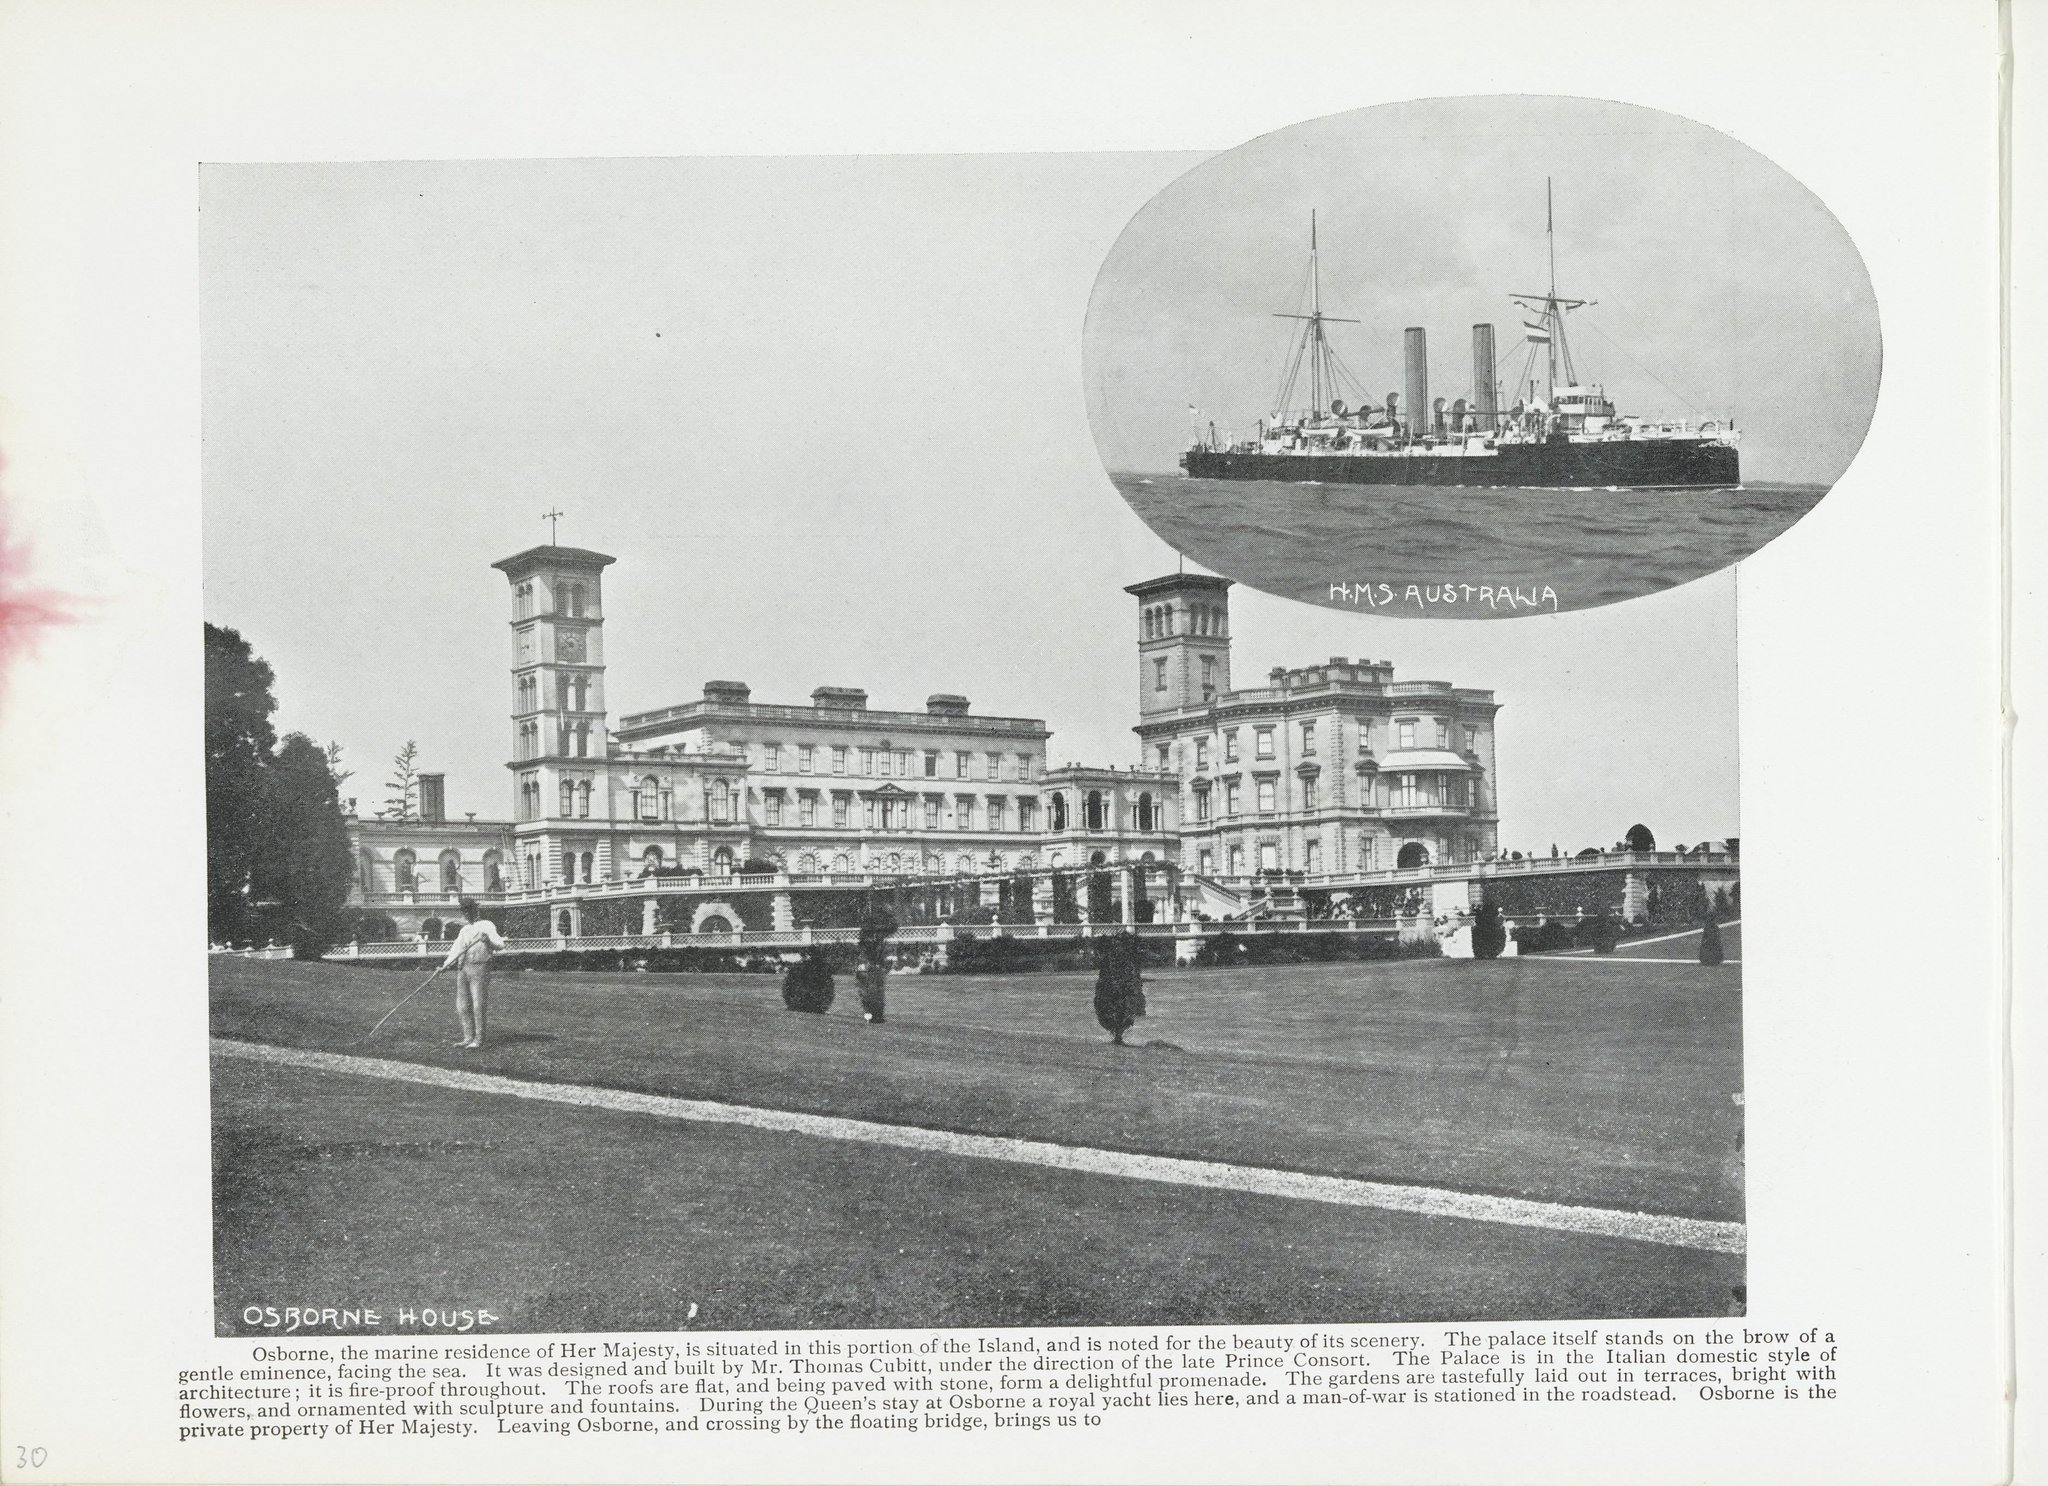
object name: page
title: Osborne House in East Cowes en H.M.S. Australia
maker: Anonymous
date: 1897-1930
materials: paper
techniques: printing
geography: isle of wight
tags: garden, palace, sailing-ship, sailing-boat (with name), travelling; tourism, isle of wight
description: Pagina 30 met 2 foto's van Osborne House in East Cowes, van H.M.S. Australia en een bijschrift. Onderdeel van Fotografische reisreportage van het eiland Wight.